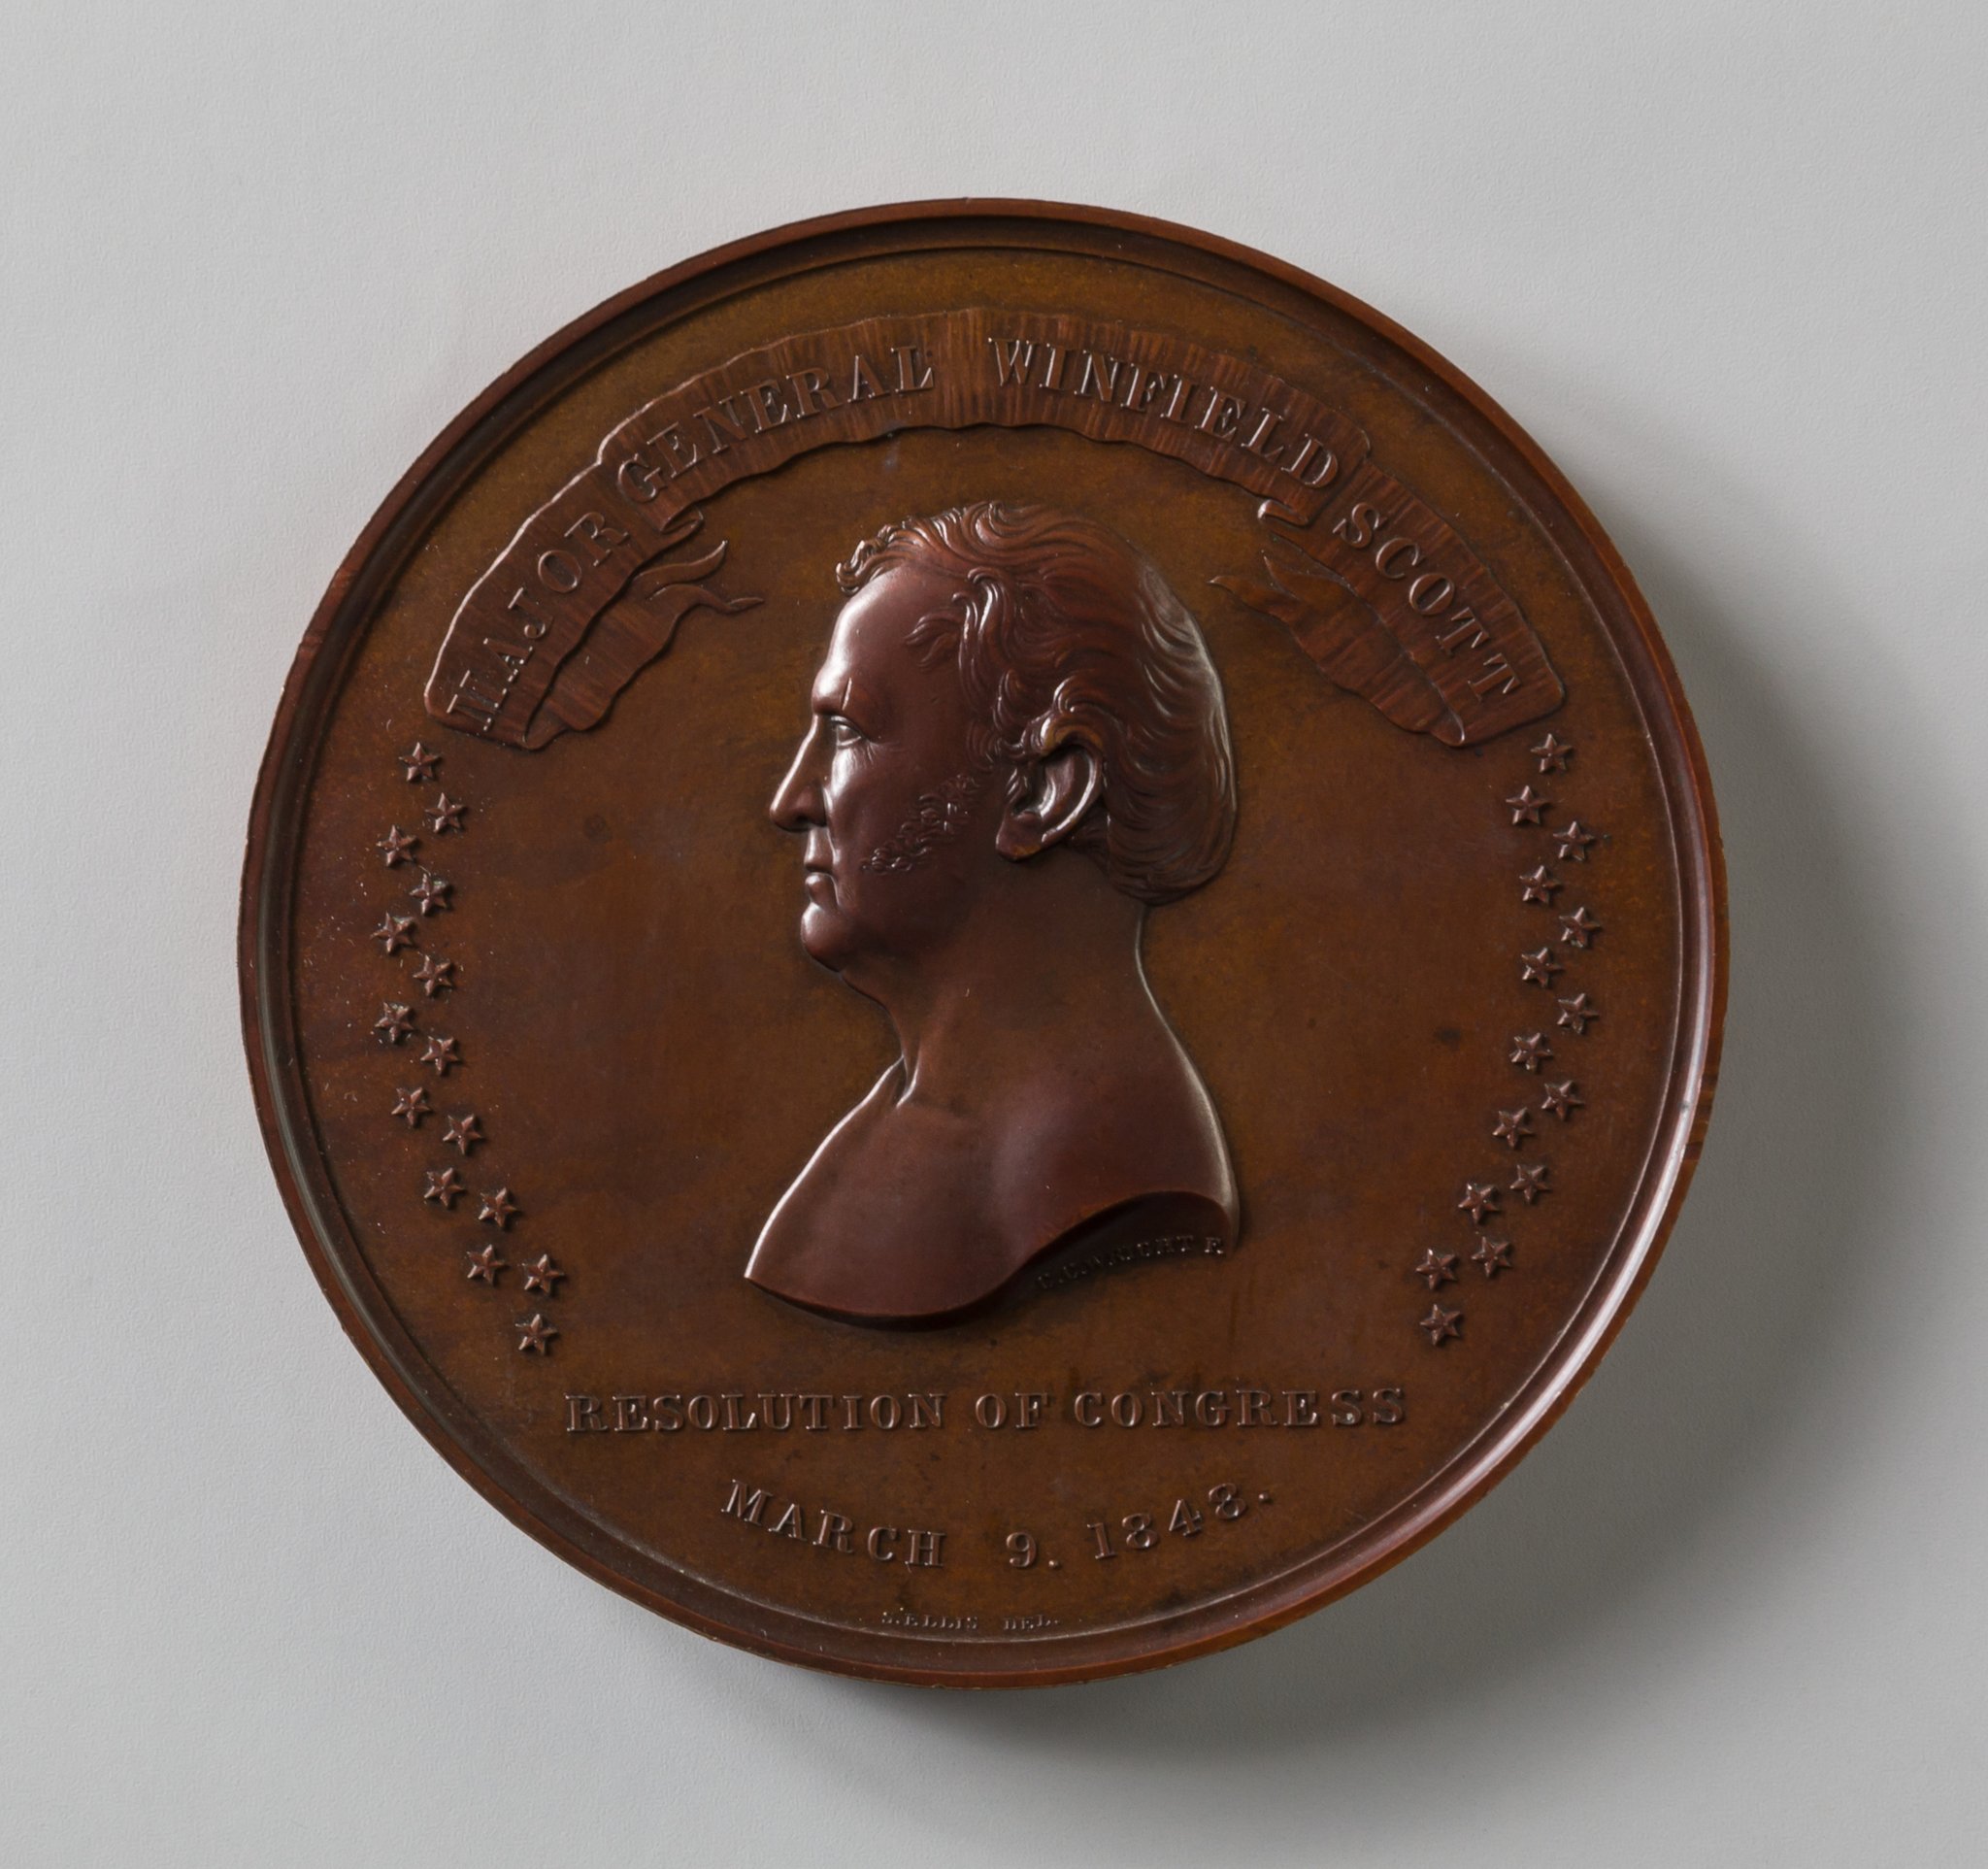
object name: medal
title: Medal of General Winfield Scott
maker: charles cushing wright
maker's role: maker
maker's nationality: american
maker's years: 1796-1854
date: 1848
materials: bronze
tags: men,profiles